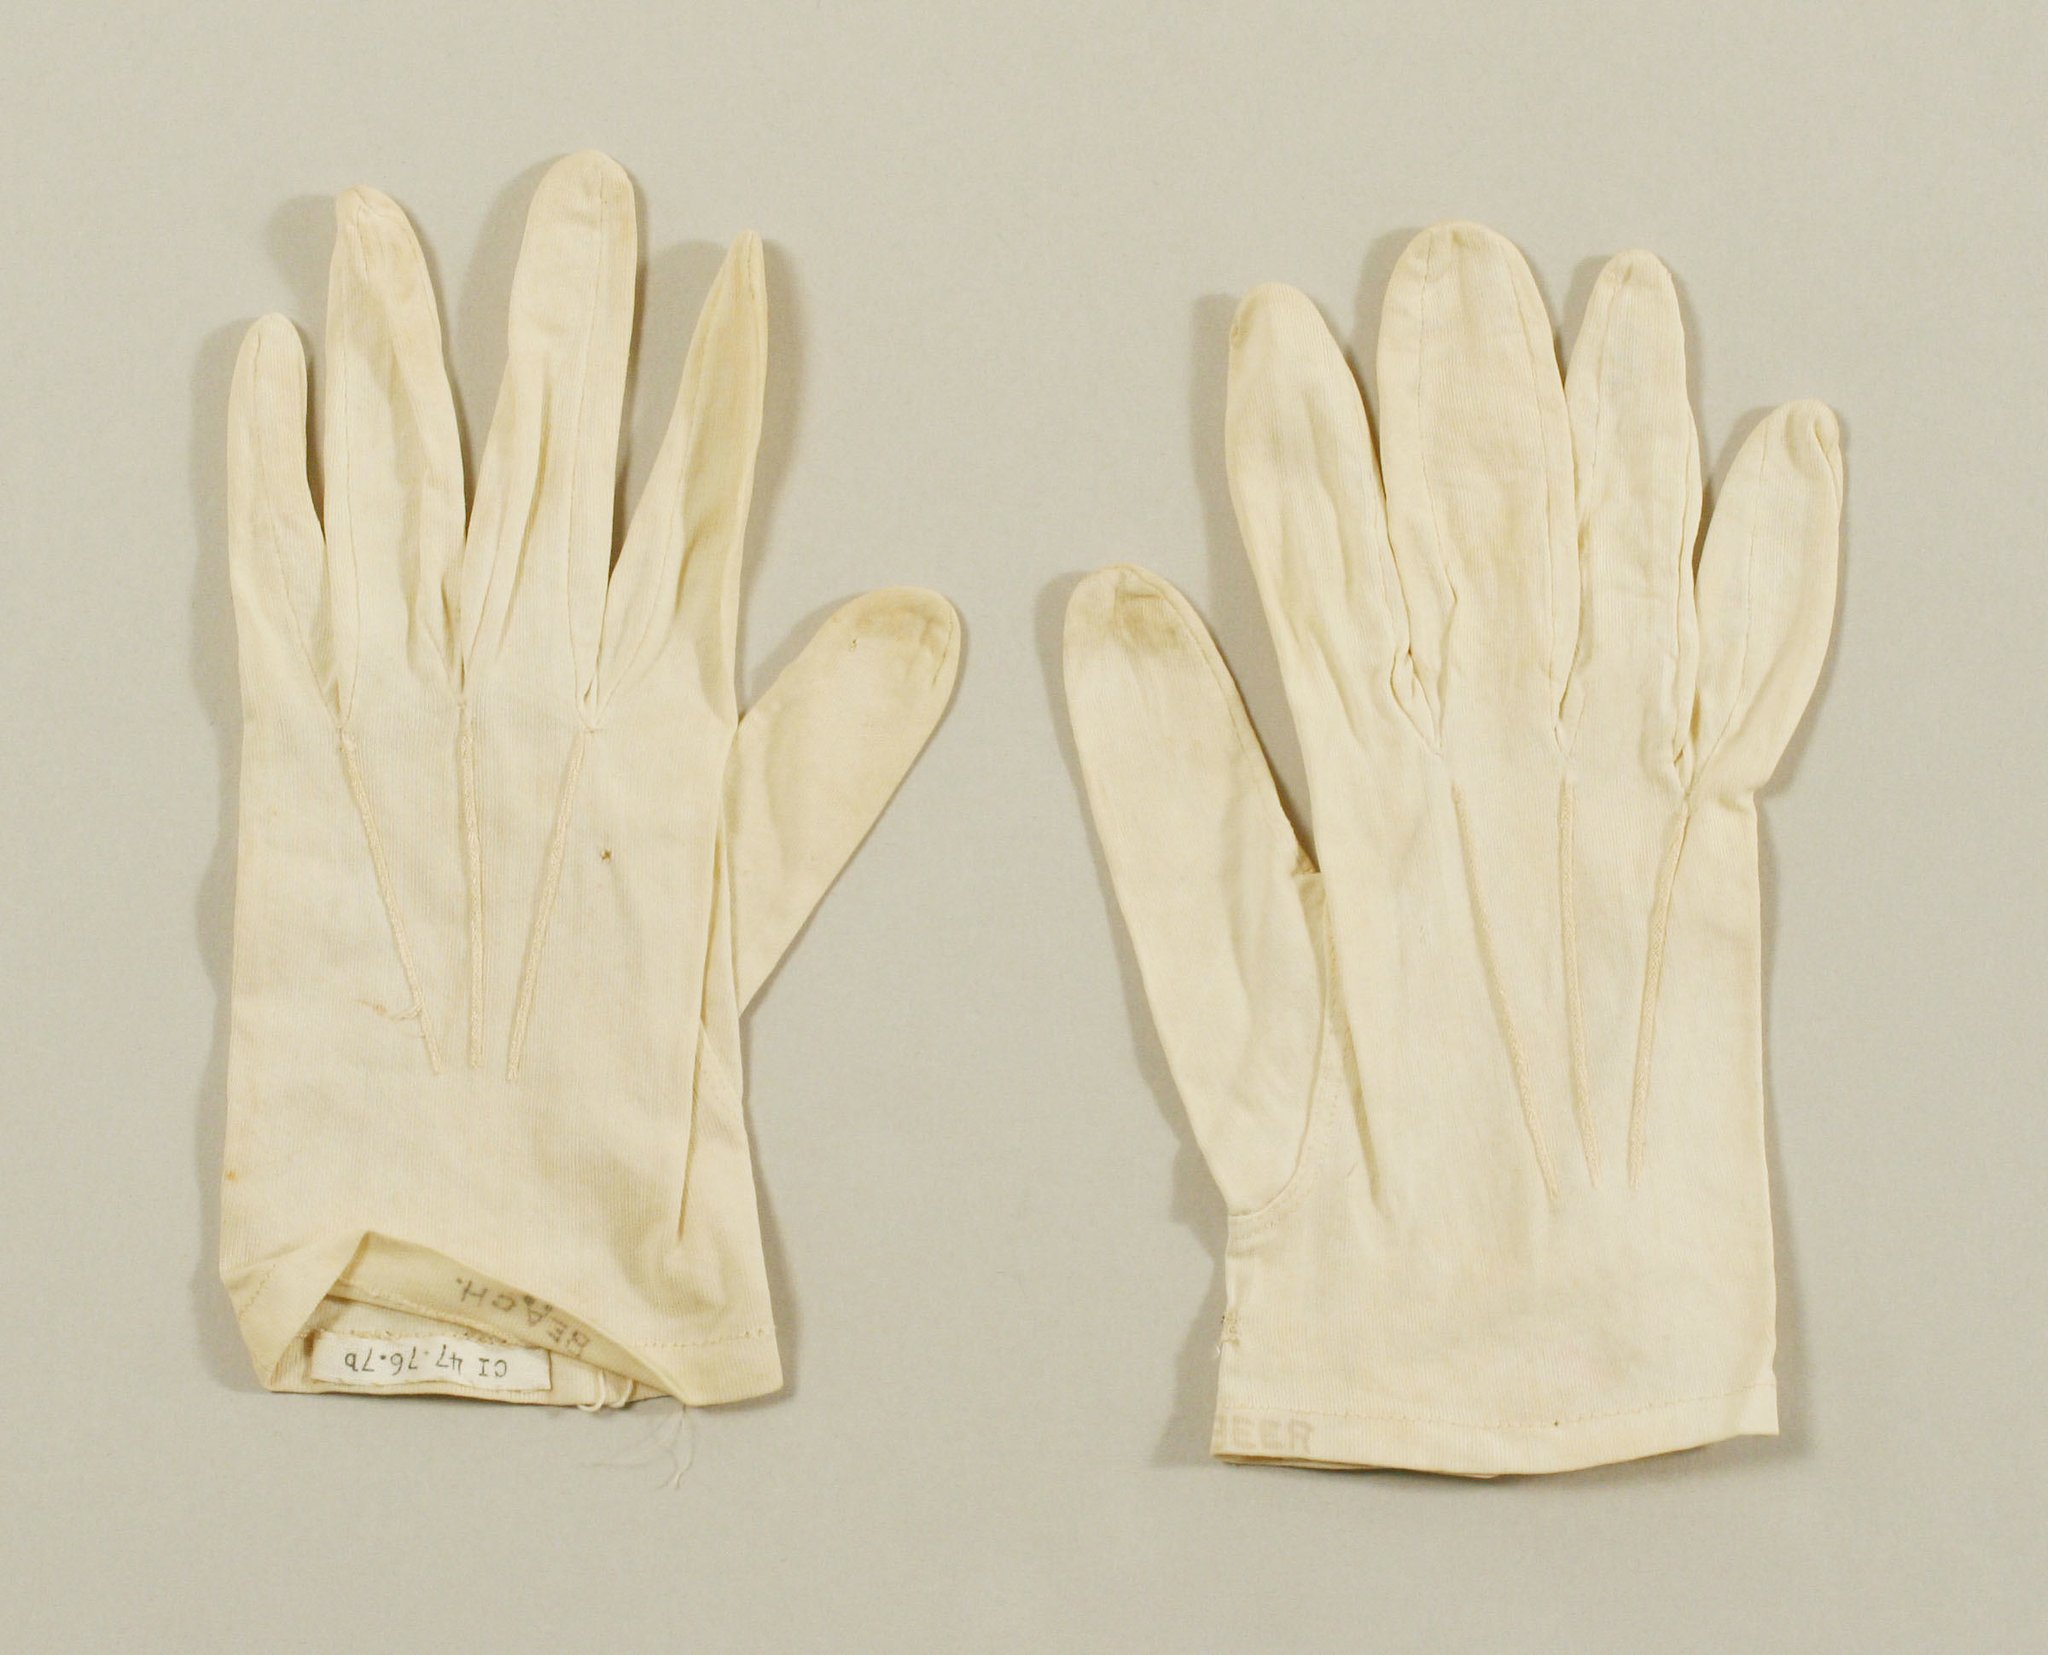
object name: glove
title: Gloves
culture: american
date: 1880-1884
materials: cotton